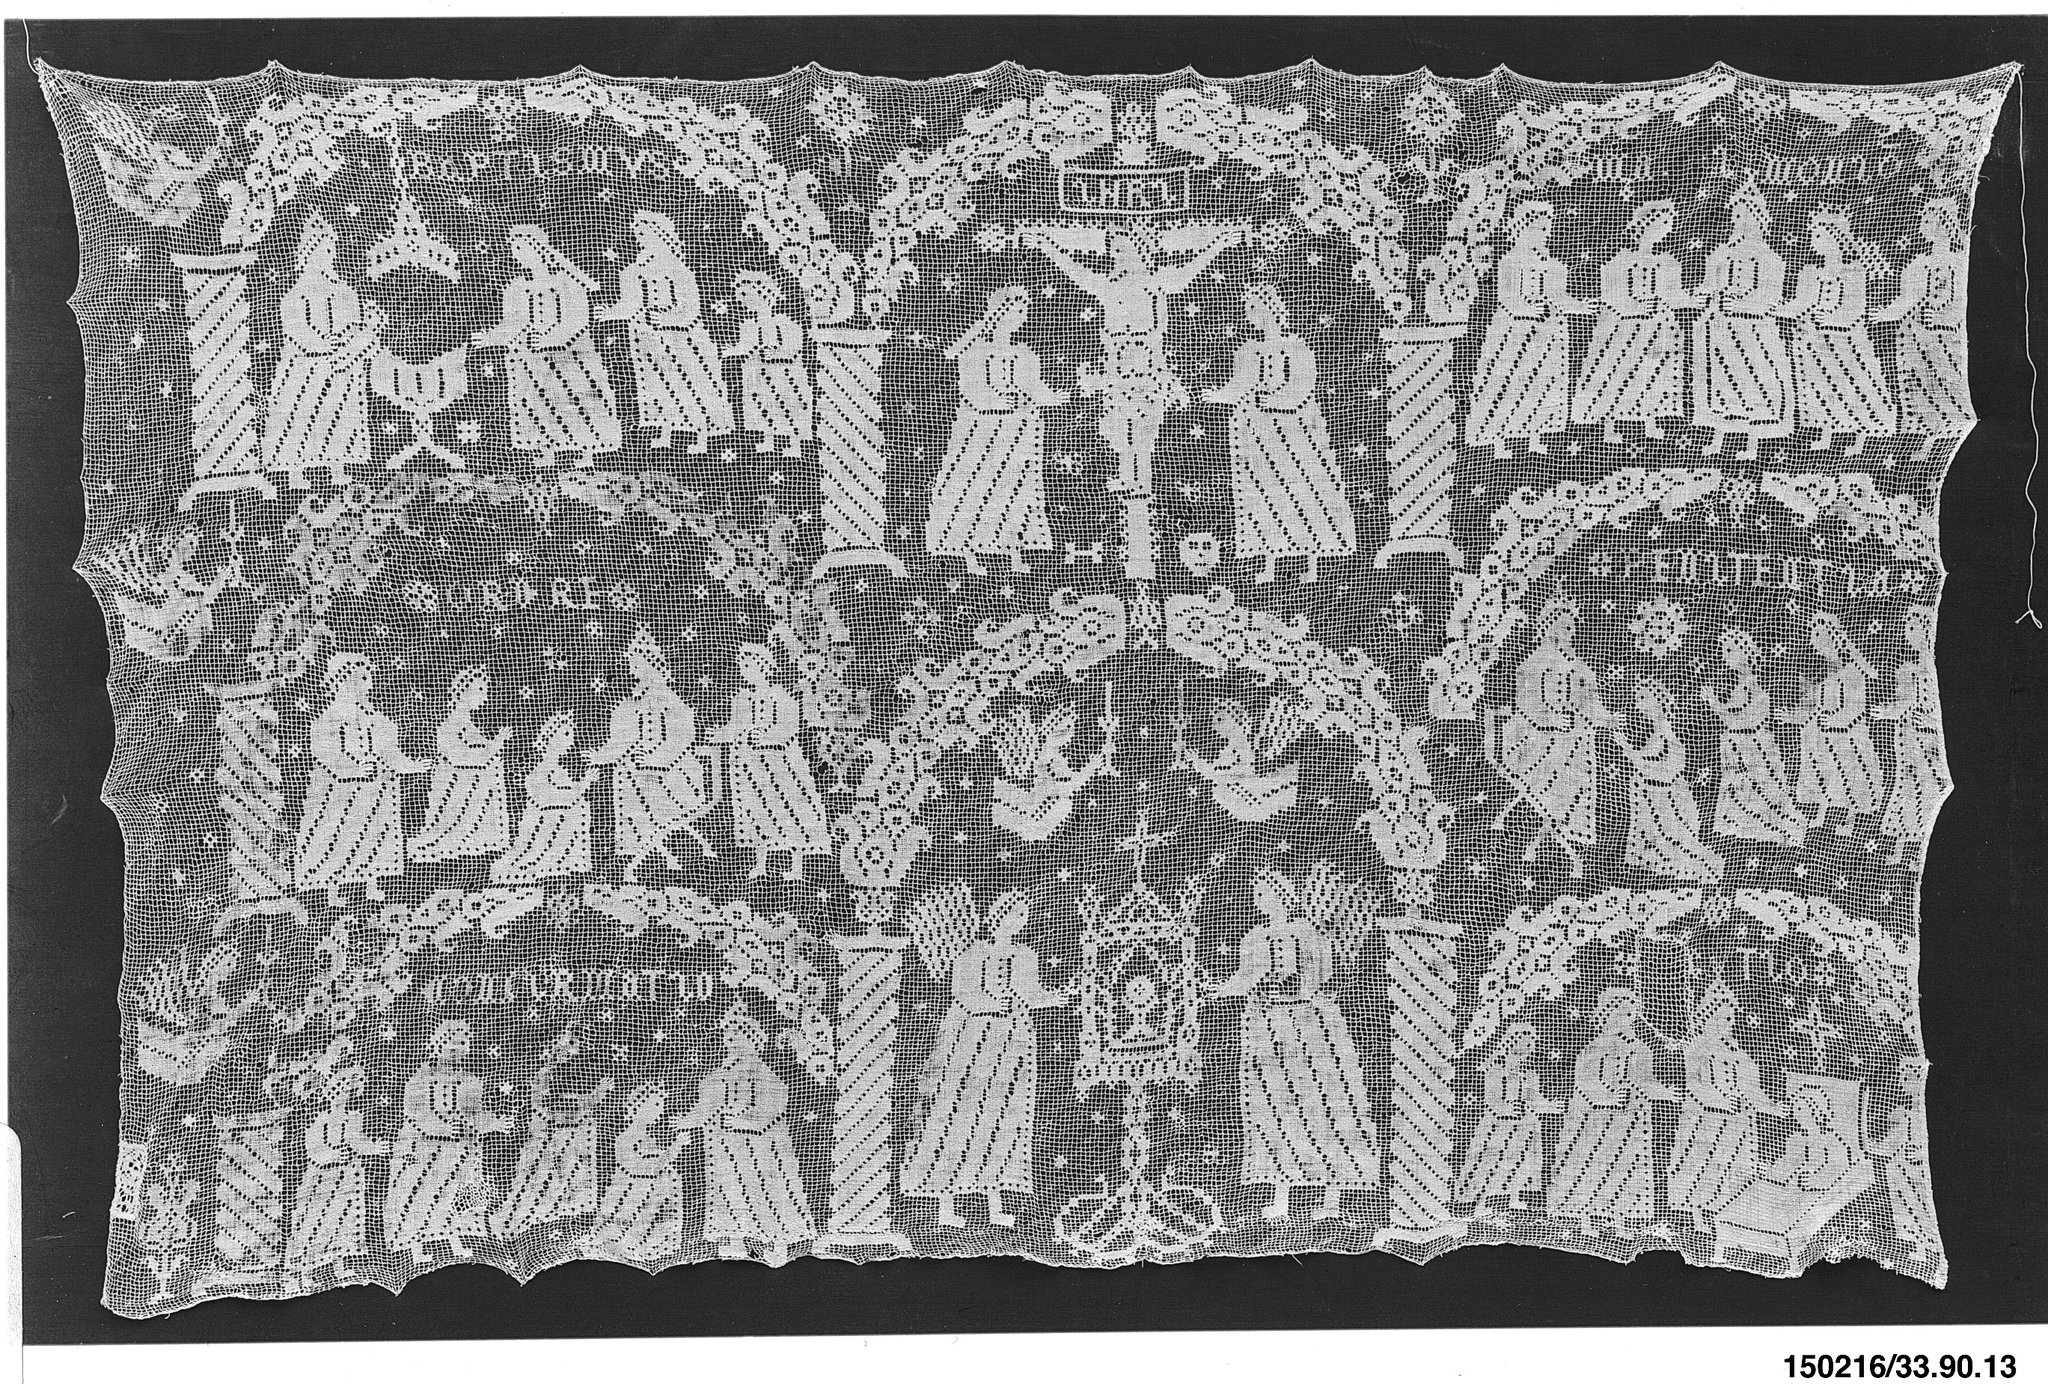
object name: panel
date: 1501-1600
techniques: embroidery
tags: women,angels,jesus,crucifixion